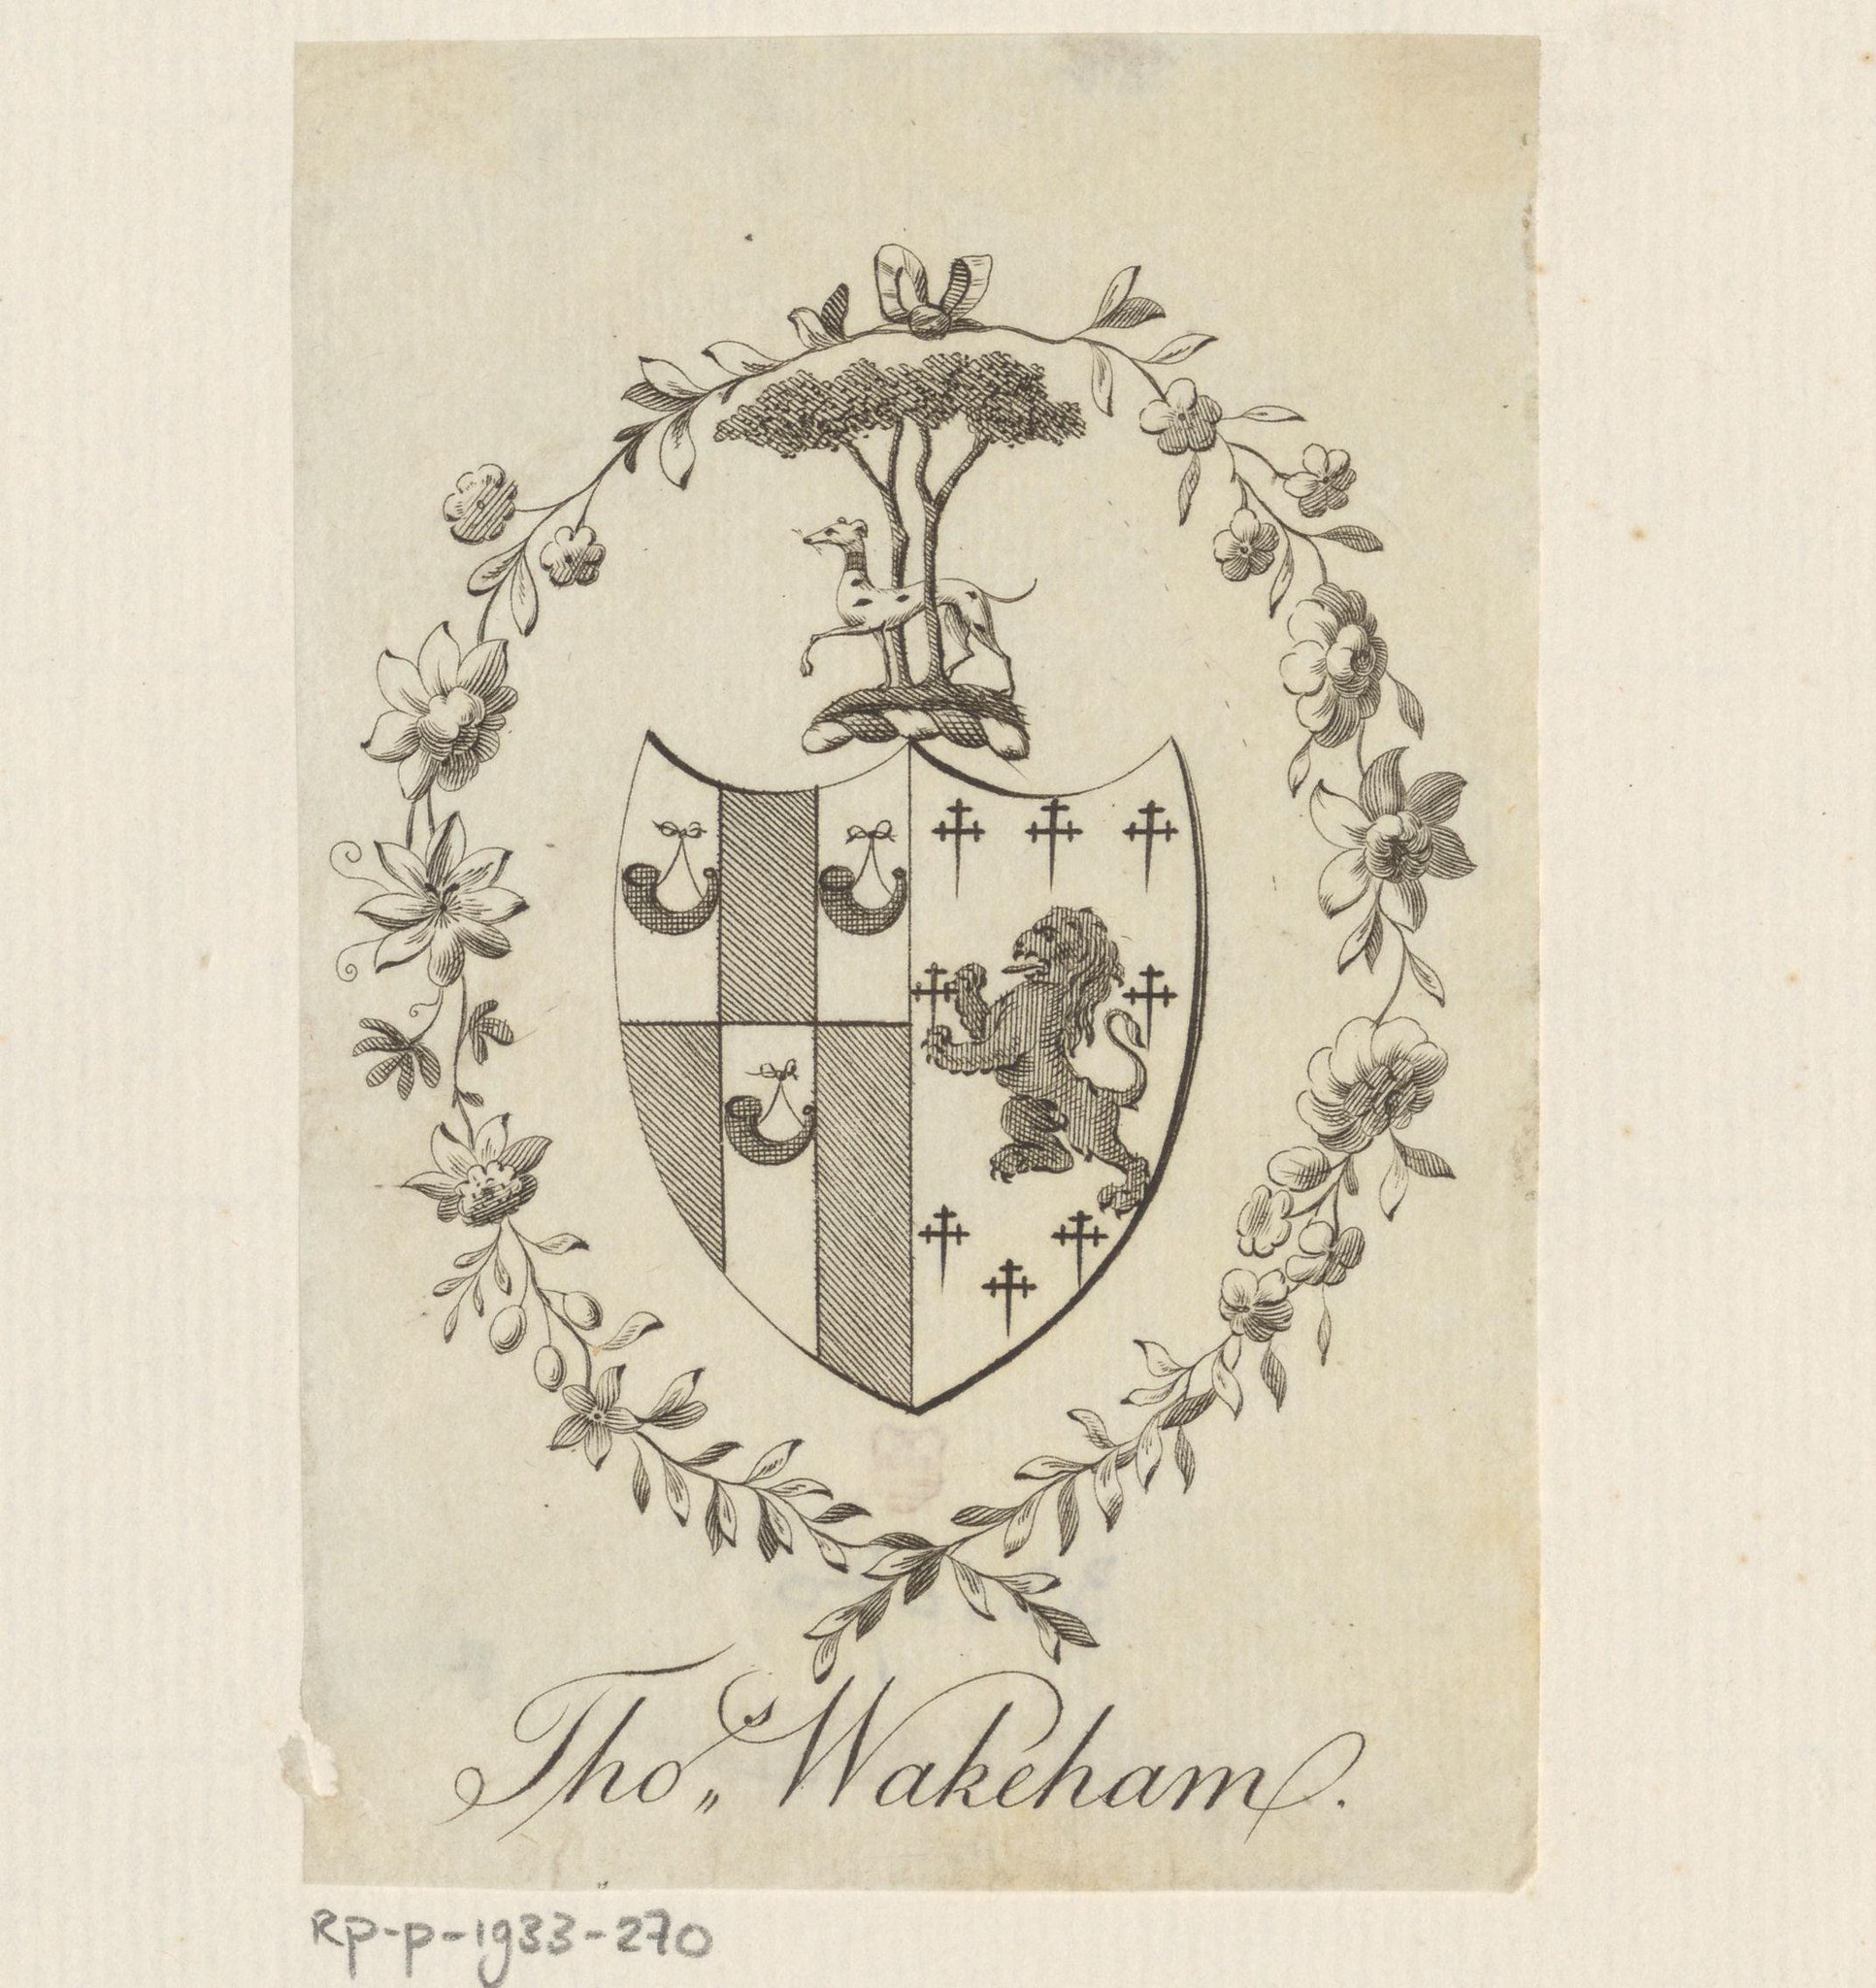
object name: bookplate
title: Ex libris van Tho. Wakeham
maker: Anonymous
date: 1750-1849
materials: paper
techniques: engraving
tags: armorial bearing, heraldry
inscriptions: collector's mark: Lugt 2760